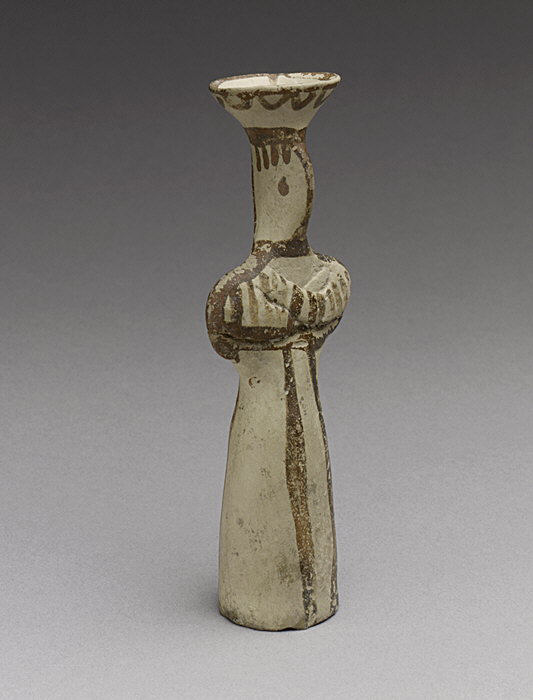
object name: statuette of a woman tau type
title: Terracotta female figure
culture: aegean, helladic or mycenaean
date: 1400-1300 BCE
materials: terracotta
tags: women